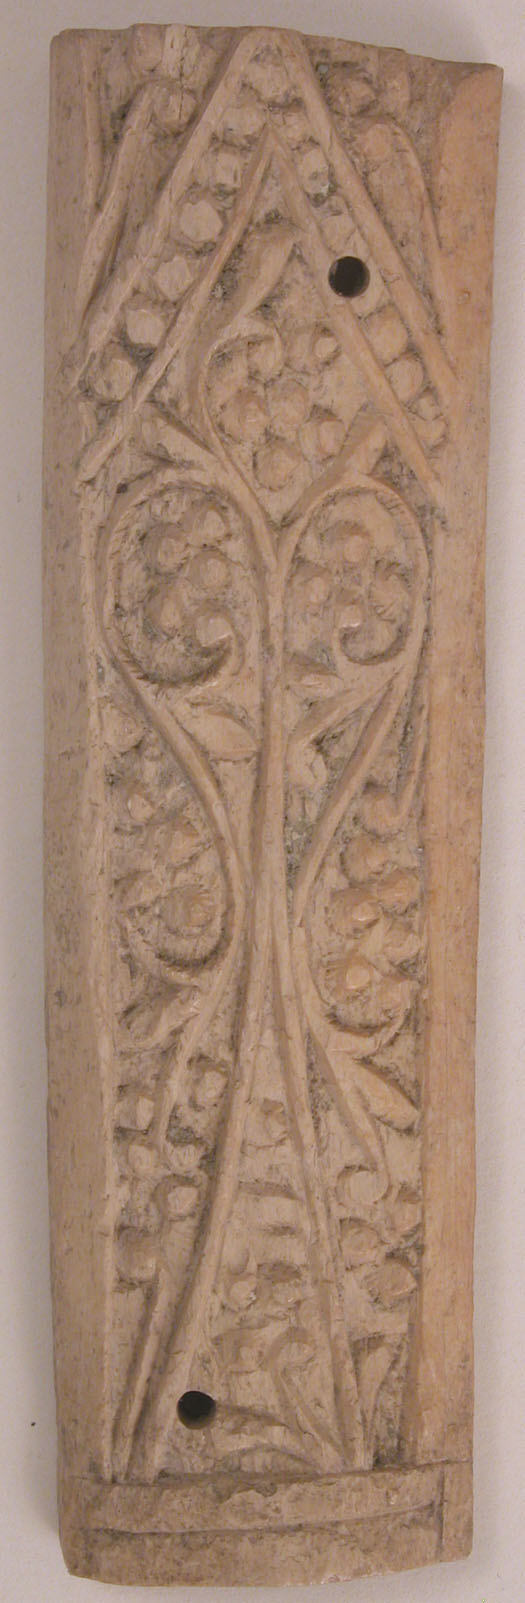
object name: plaque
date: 501-700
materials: bone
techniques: carving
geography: egypt